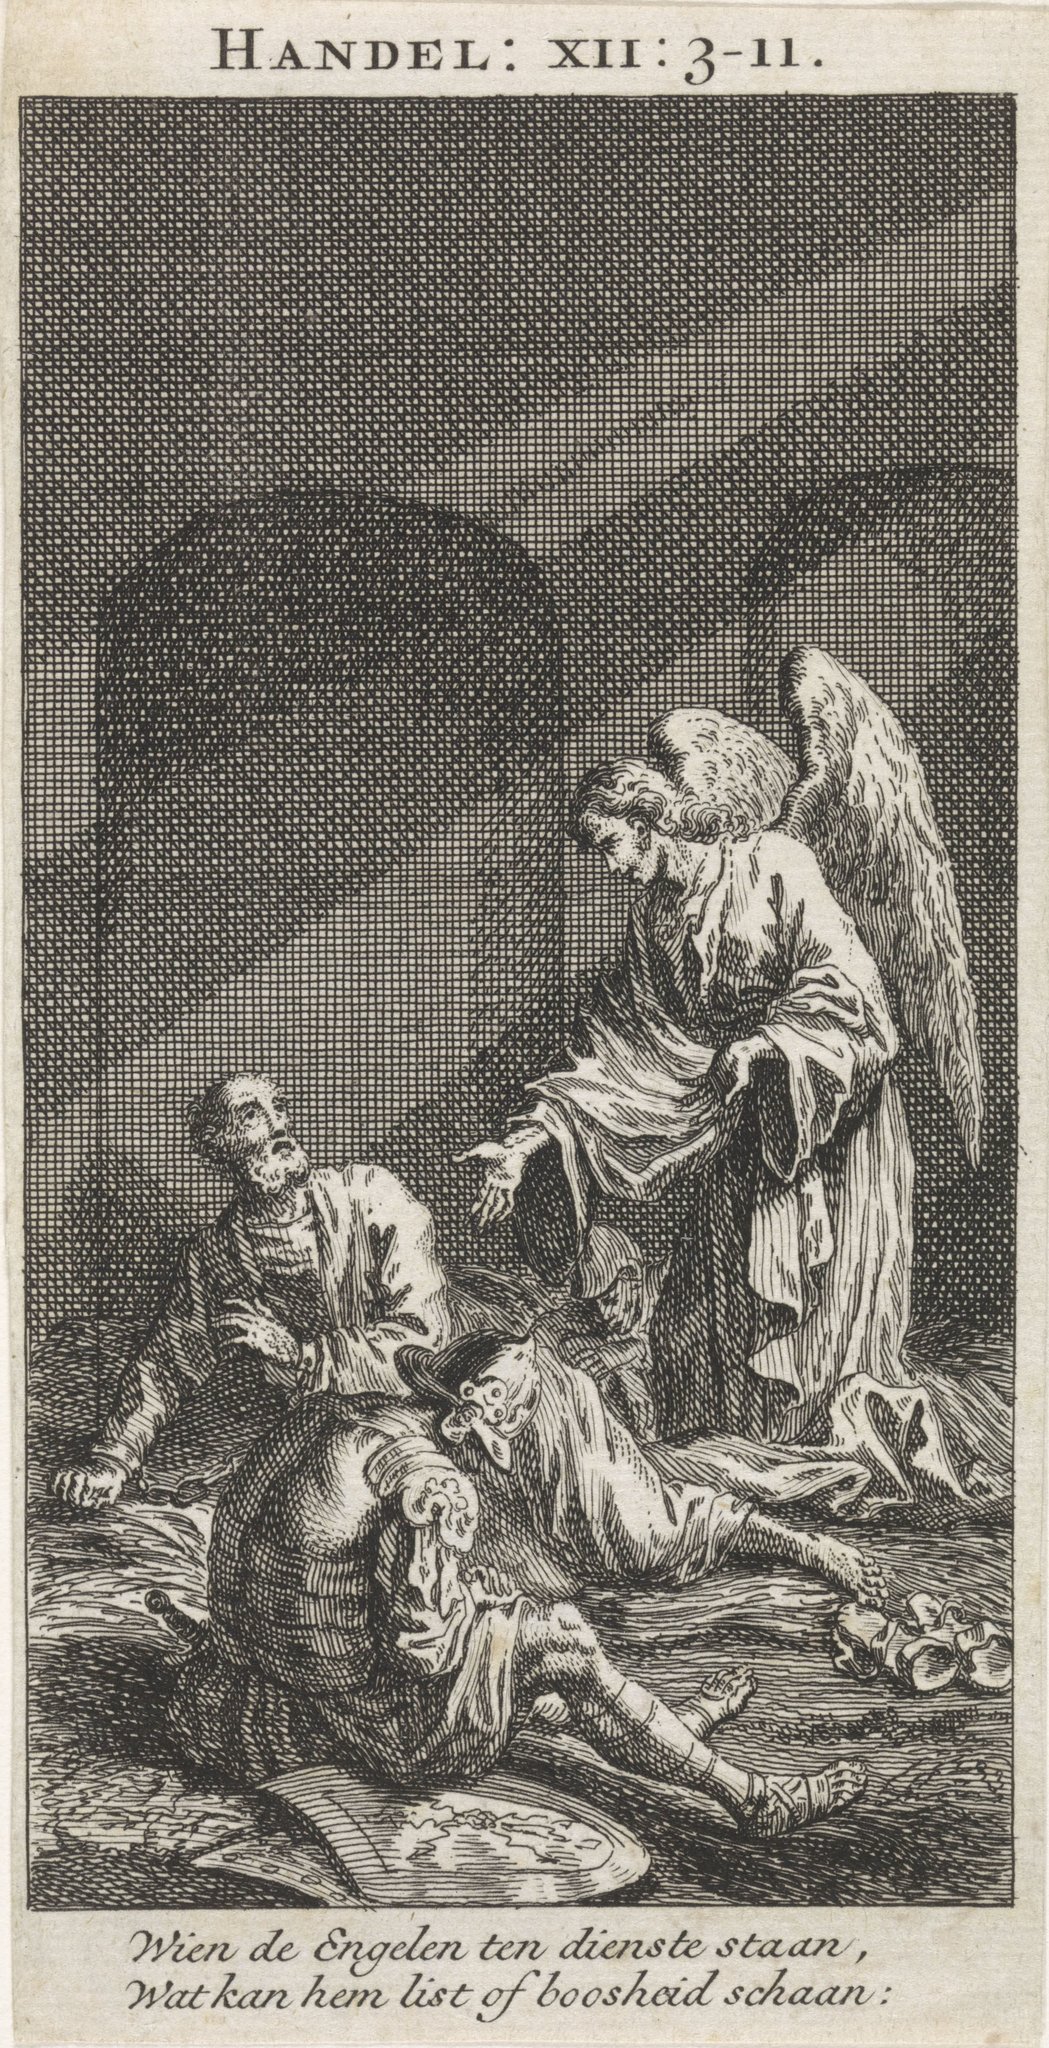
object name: print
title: Bevrijding van Petrus uit de gevangenis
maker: Anonymous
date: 1712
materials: paper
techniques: etching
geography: amsterdam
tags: prison, jail, the angel leads peter past the sleeping guards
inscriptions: collector's mark: Lugt 240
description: Kopie naar llustratie voor: Luyken, Jan. Bybel printen. Amsterdam: Pieter Arentsz. II (wed.) en Cornelis van der Sys, 1712, p. 40.